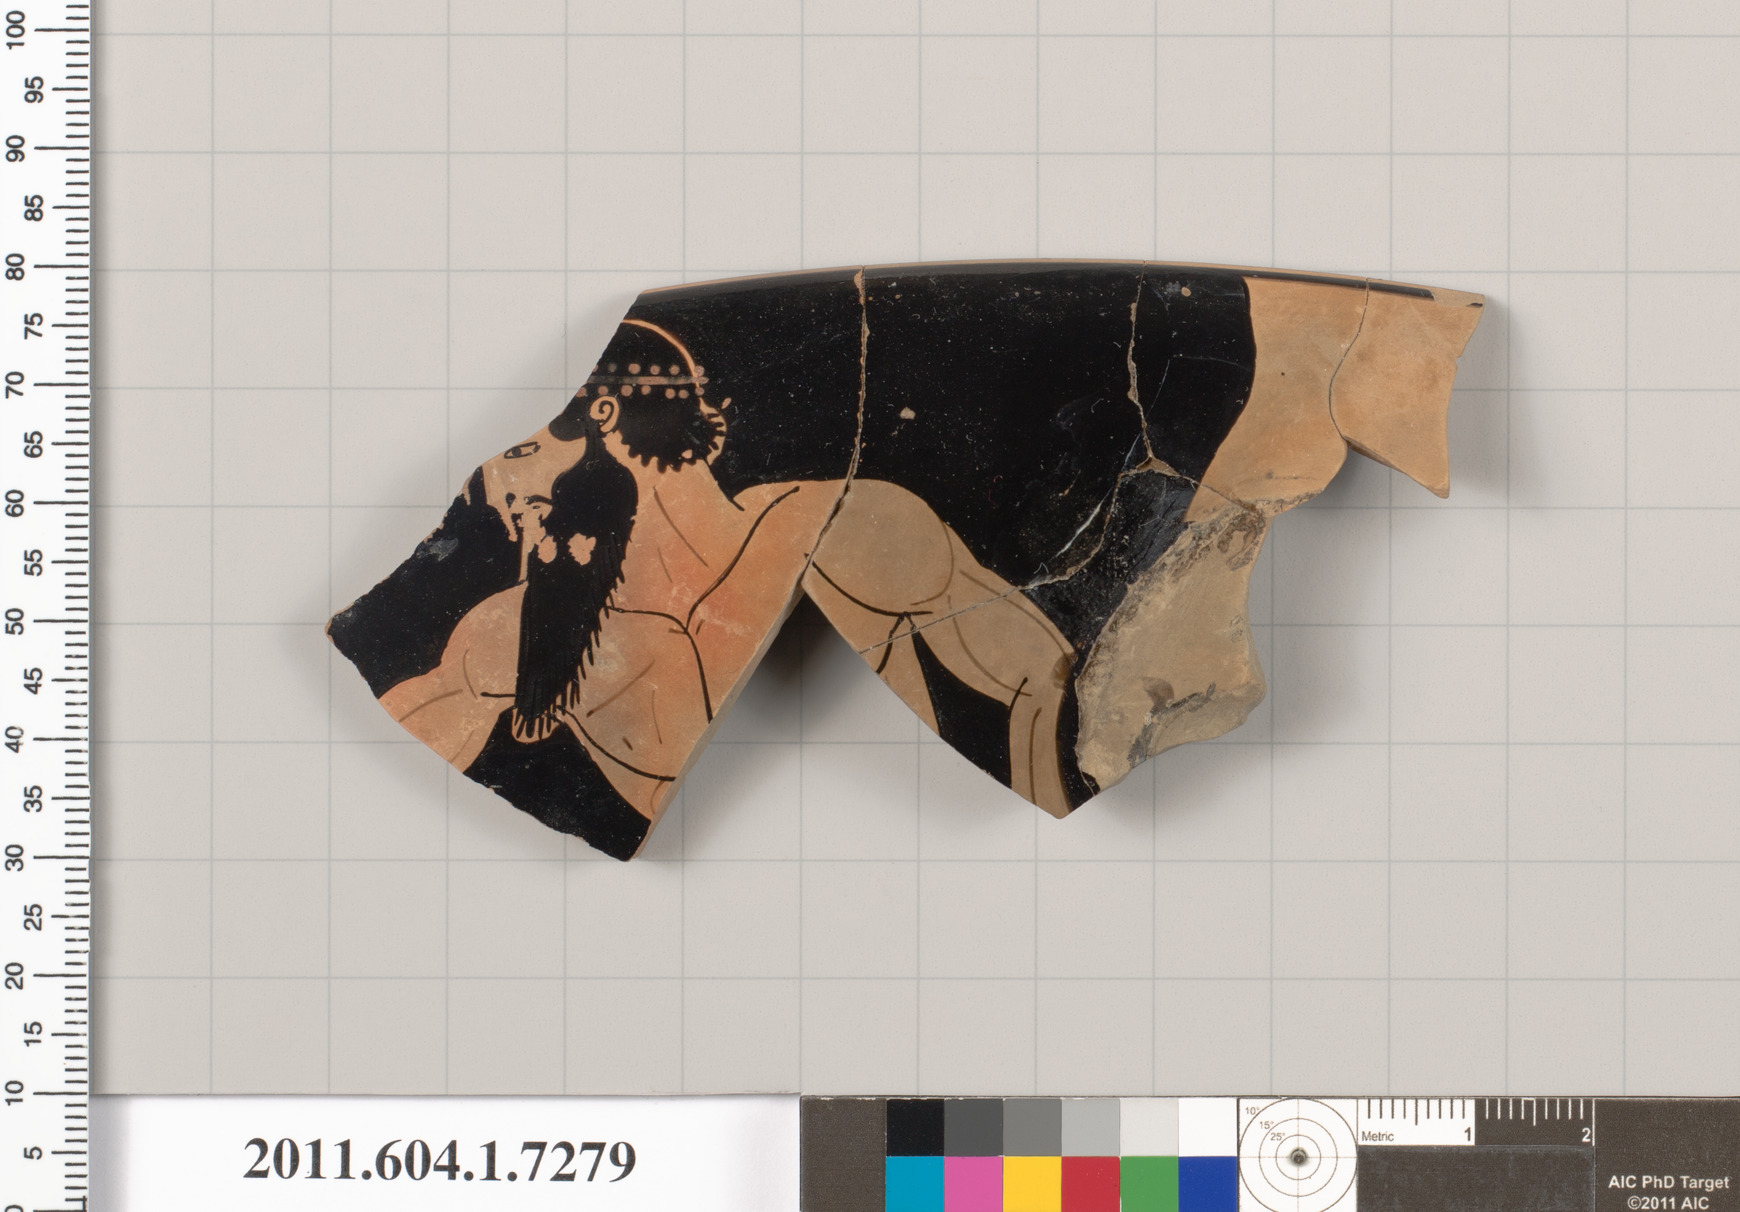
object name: kylix fragment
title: Terracotta rim fragment of a kylix (drinking cup)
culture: greek, attic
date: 500-480 BCE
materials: terracotta